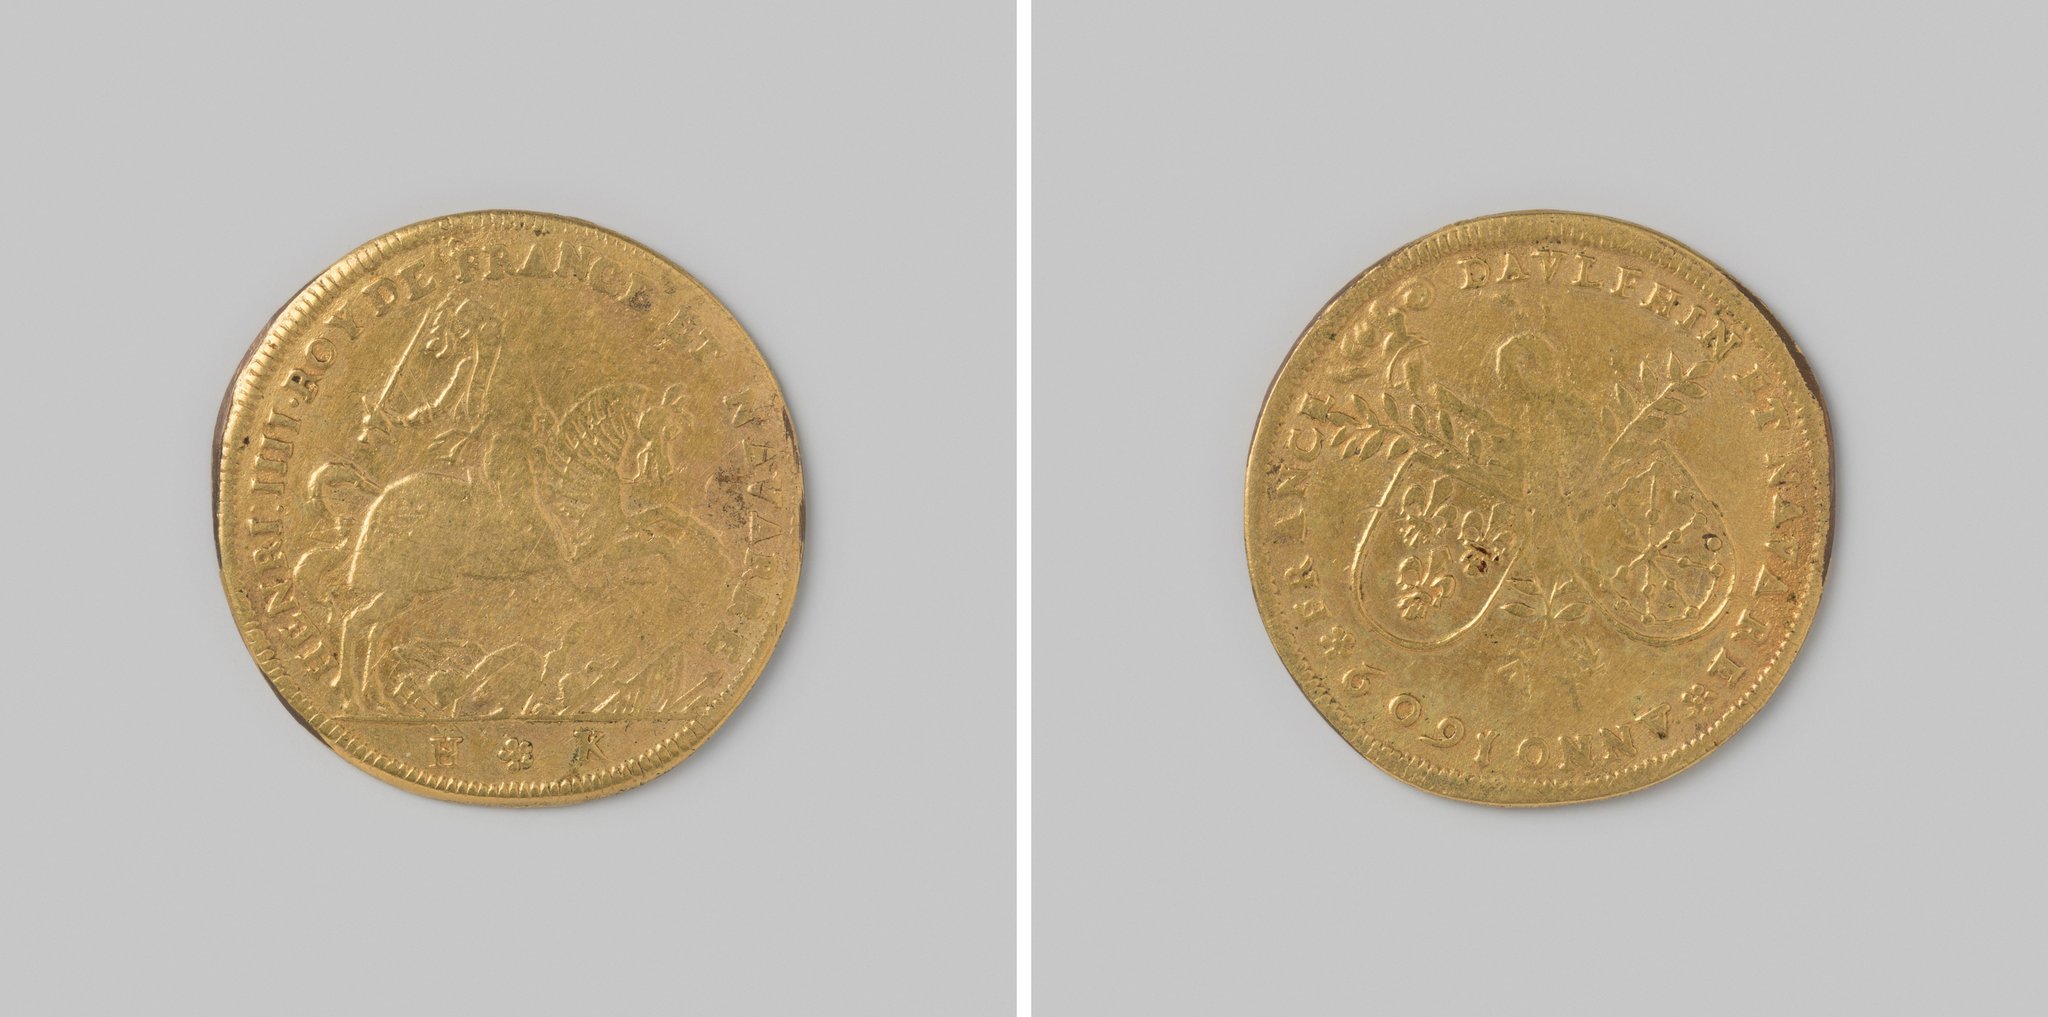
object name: history medal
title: Rekenpenning uit Neurenberg op Koning Hendrik IV van Frankrijk 1609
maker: hans krauwinckel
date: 1609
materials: brass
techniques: striking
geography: nuremberg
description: Messing penning, op de voorzijde Hendrik IV te paard naar rechts rijdend over wapentuig, met omschrift en afsnedetekst, op de keerzijde twee wapenschilden op twee lauwertakken, met omschrift.